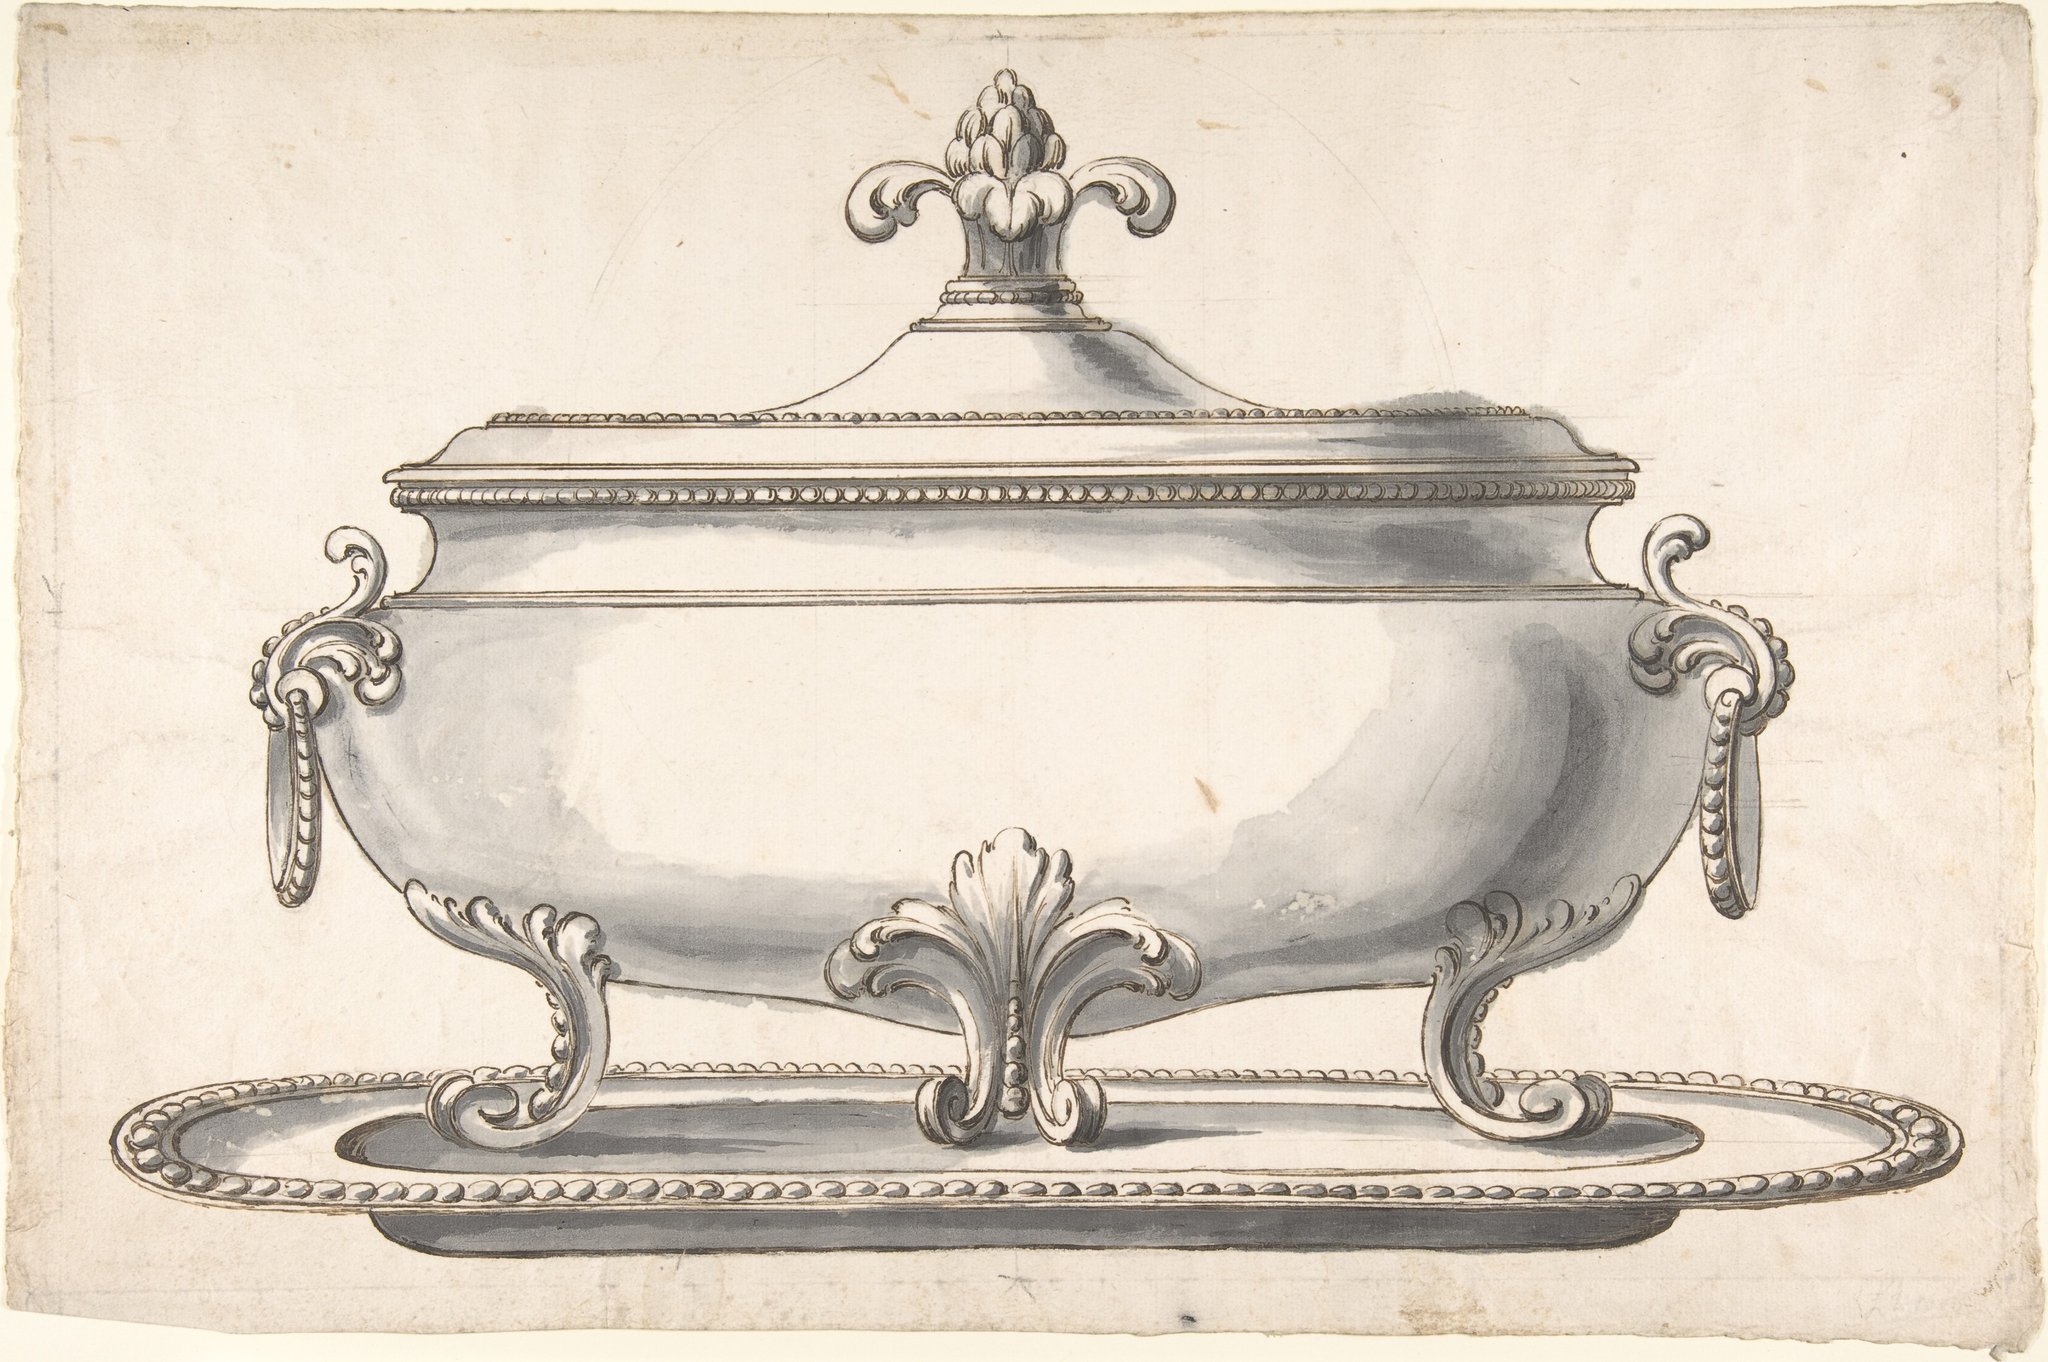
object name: drawing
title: Turreen on a Plate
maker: anonymous, italian, 19th century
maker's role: artist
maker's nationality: italian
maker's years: 1800-1900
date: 1800-1900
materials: ink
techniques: pen, wash